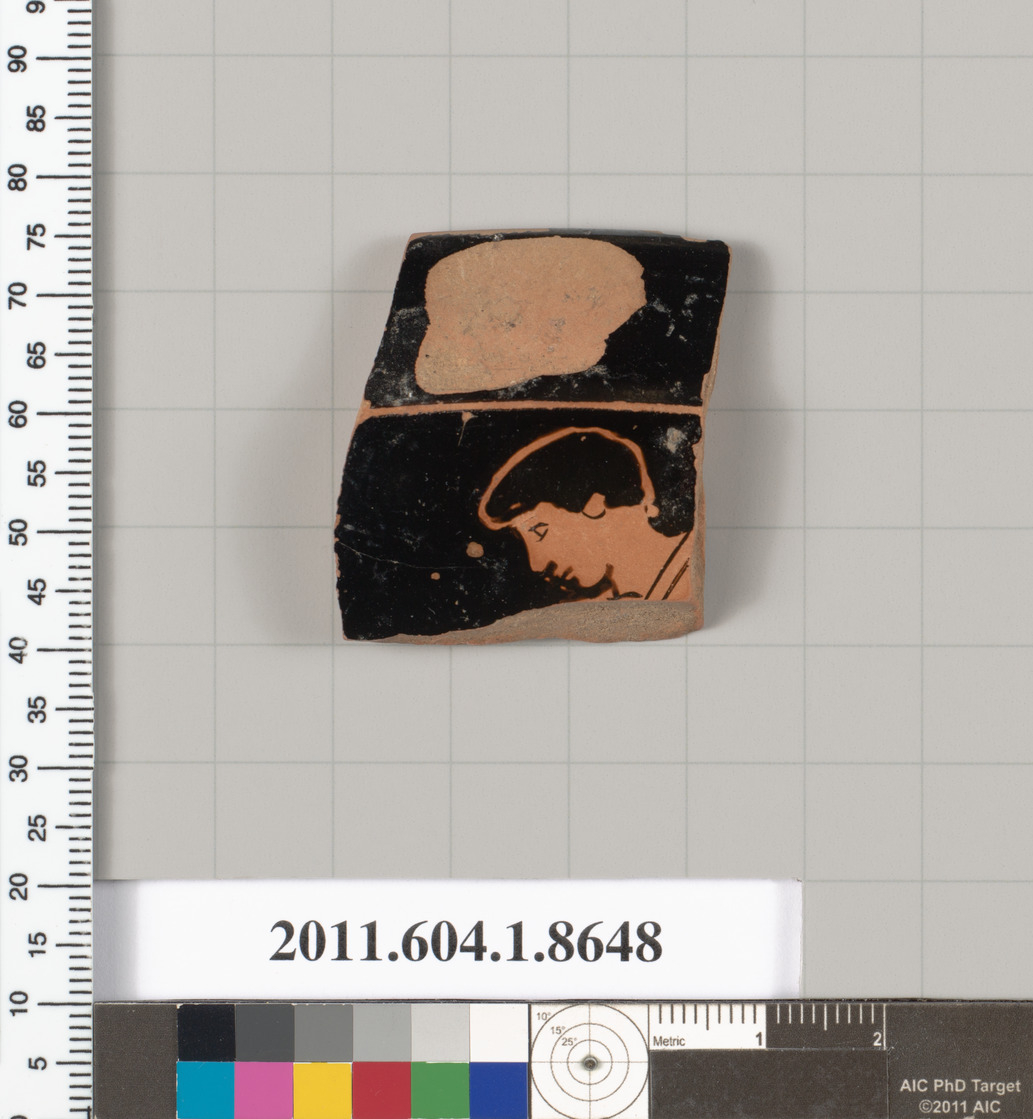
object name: kylix fragment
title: Terracotta rim fragment of a stemless? kylix (drinking cup)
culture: greek, attic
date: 460-450 BCE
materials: terracotta